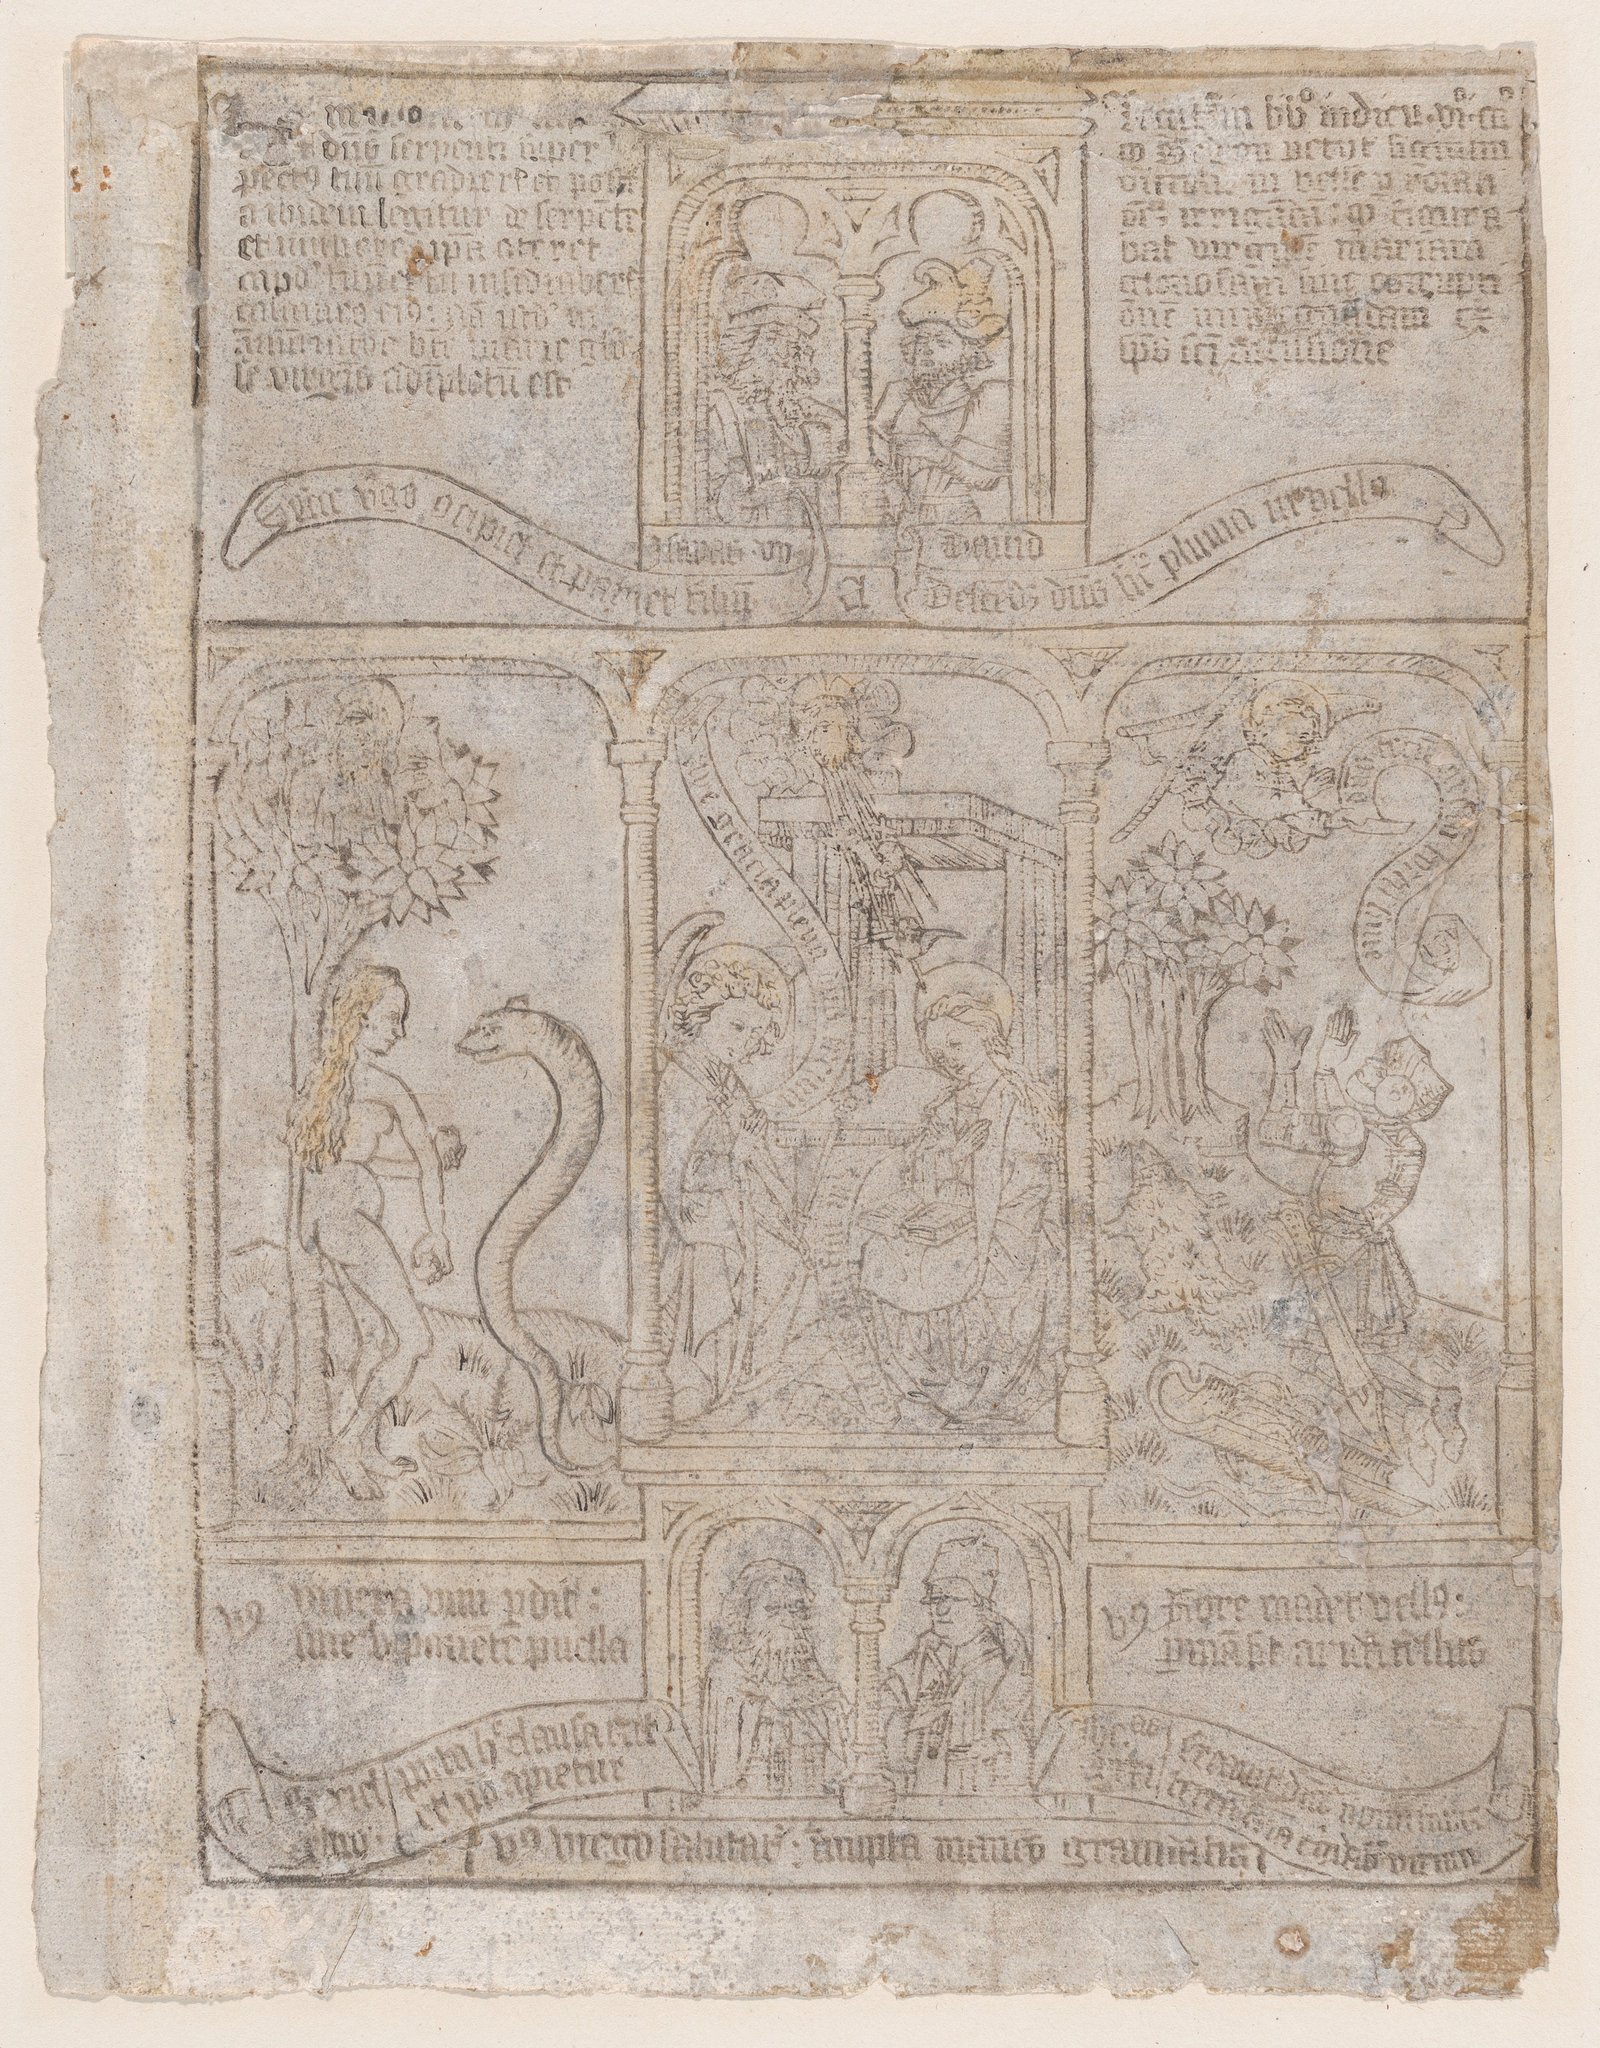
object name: print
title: The Annunciation, flanked by Eve and the Serpent and Gideon's Fleece, from a "Biblia Pauperum" blockbook, third edition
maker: anonymous, netherlandish, 15th century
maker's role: artist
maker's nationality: netherlandish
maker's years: 1400-1500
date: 1465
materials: ink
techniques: hand coloring, printing, woodcut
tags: serpents,eve